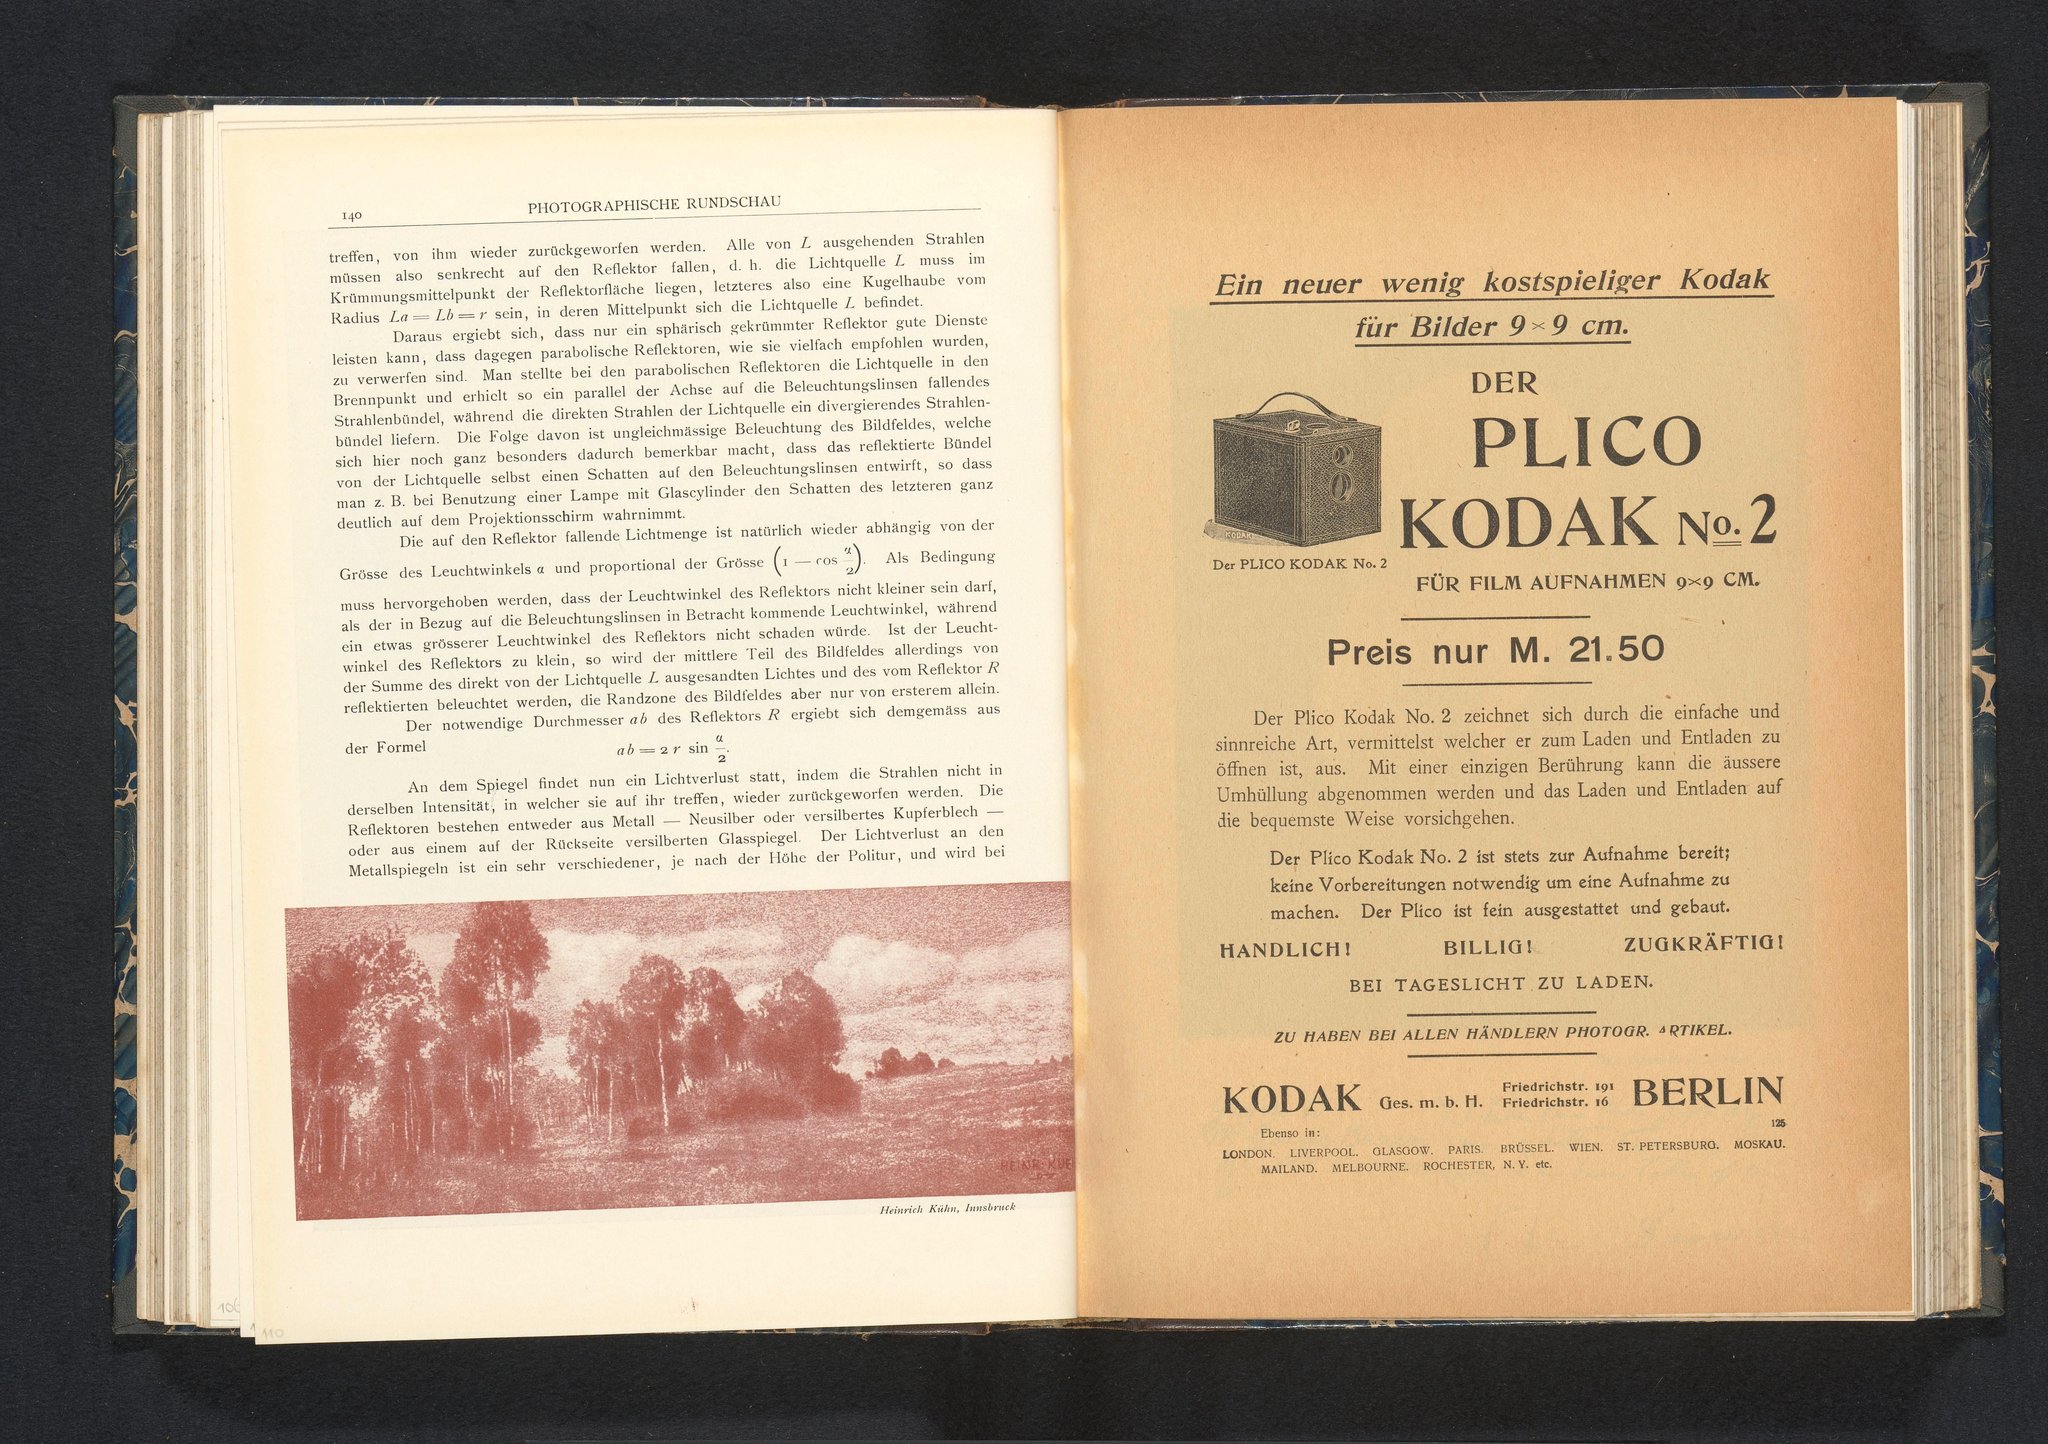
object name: page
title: Reproductie van een schilderij van een landschap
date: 1897-1901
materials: paper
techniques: autotype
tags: landscapes